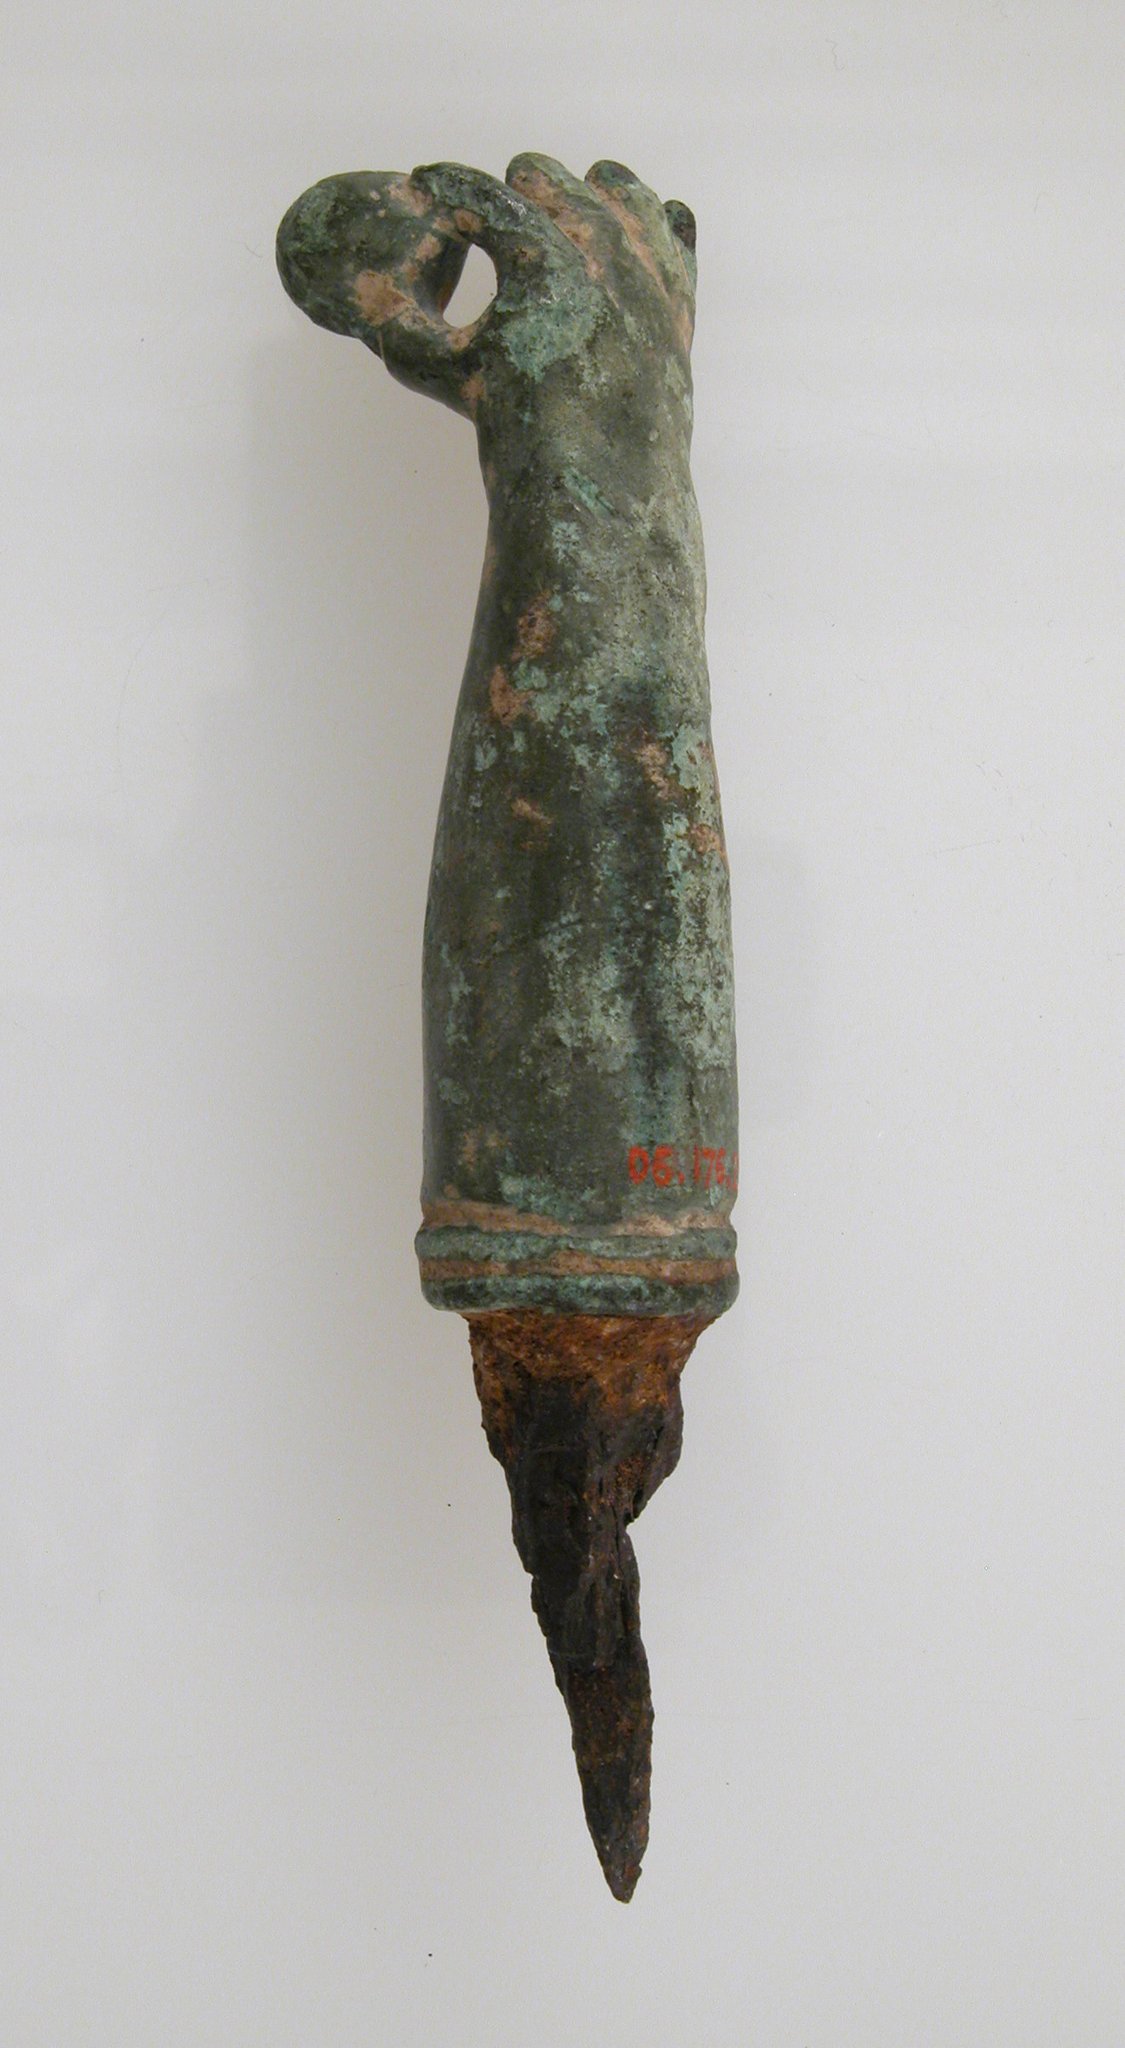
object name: key handle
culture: roman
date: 1-700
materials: copper alloy